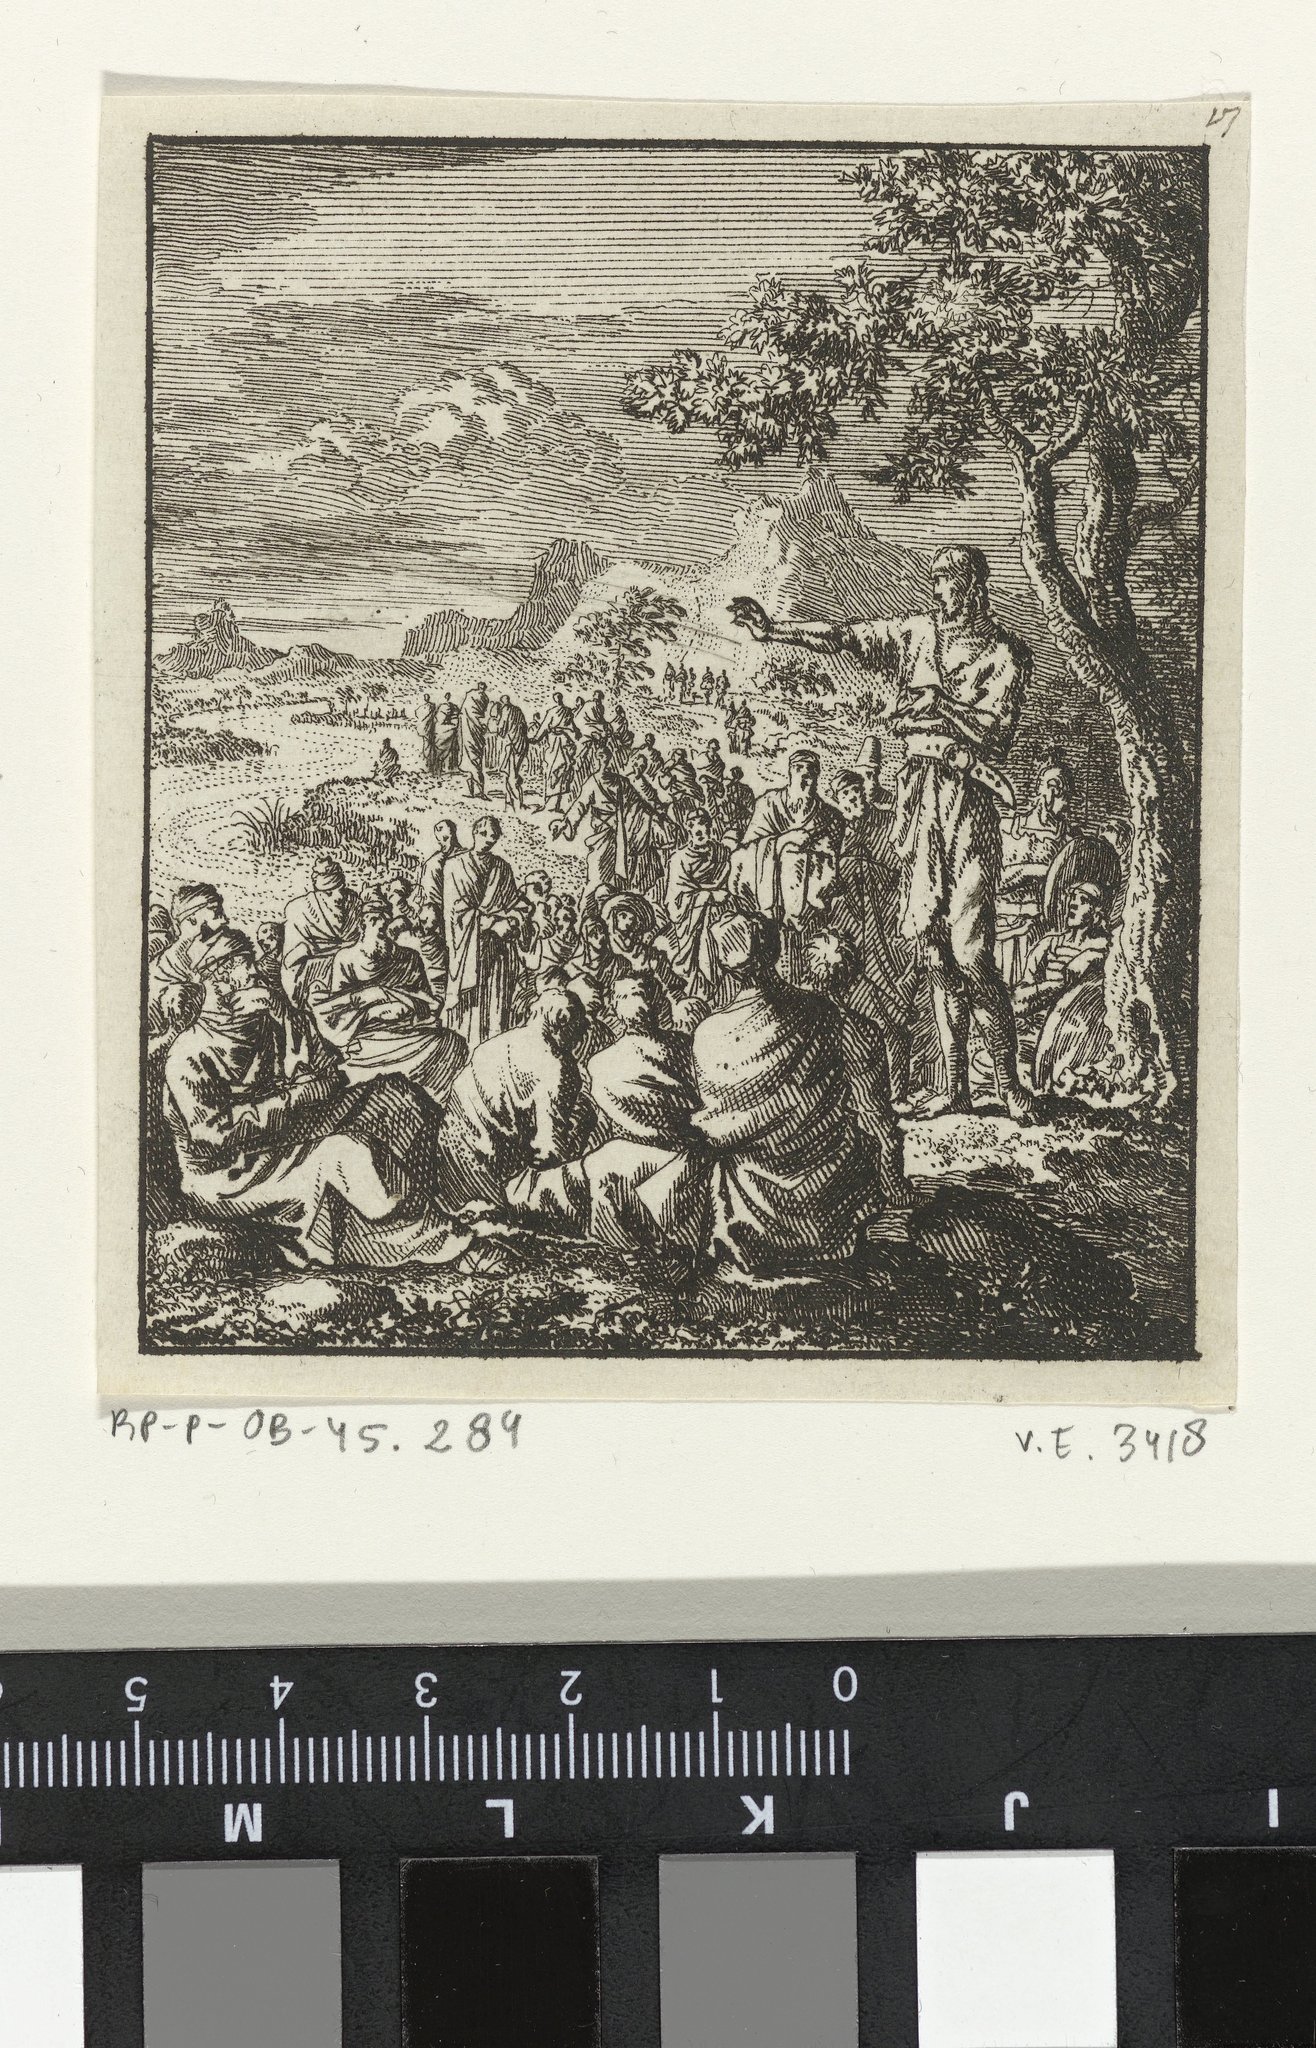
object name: book illustration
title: Prediking van Johannes de Doper aan de oevers van de Jordaan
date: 1706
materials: paper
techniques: etching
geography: amsterdam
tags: john the baptist disputing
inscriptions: collector's mark: Lugt 2228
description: Illustratie voor: Schabaalje, Jean Philipsz. De vermeerderde lust-hof des gemoeds. Amsterdam: Jan Rieuwertsz. (II) en Barent Visscher, 1706, p. 346.